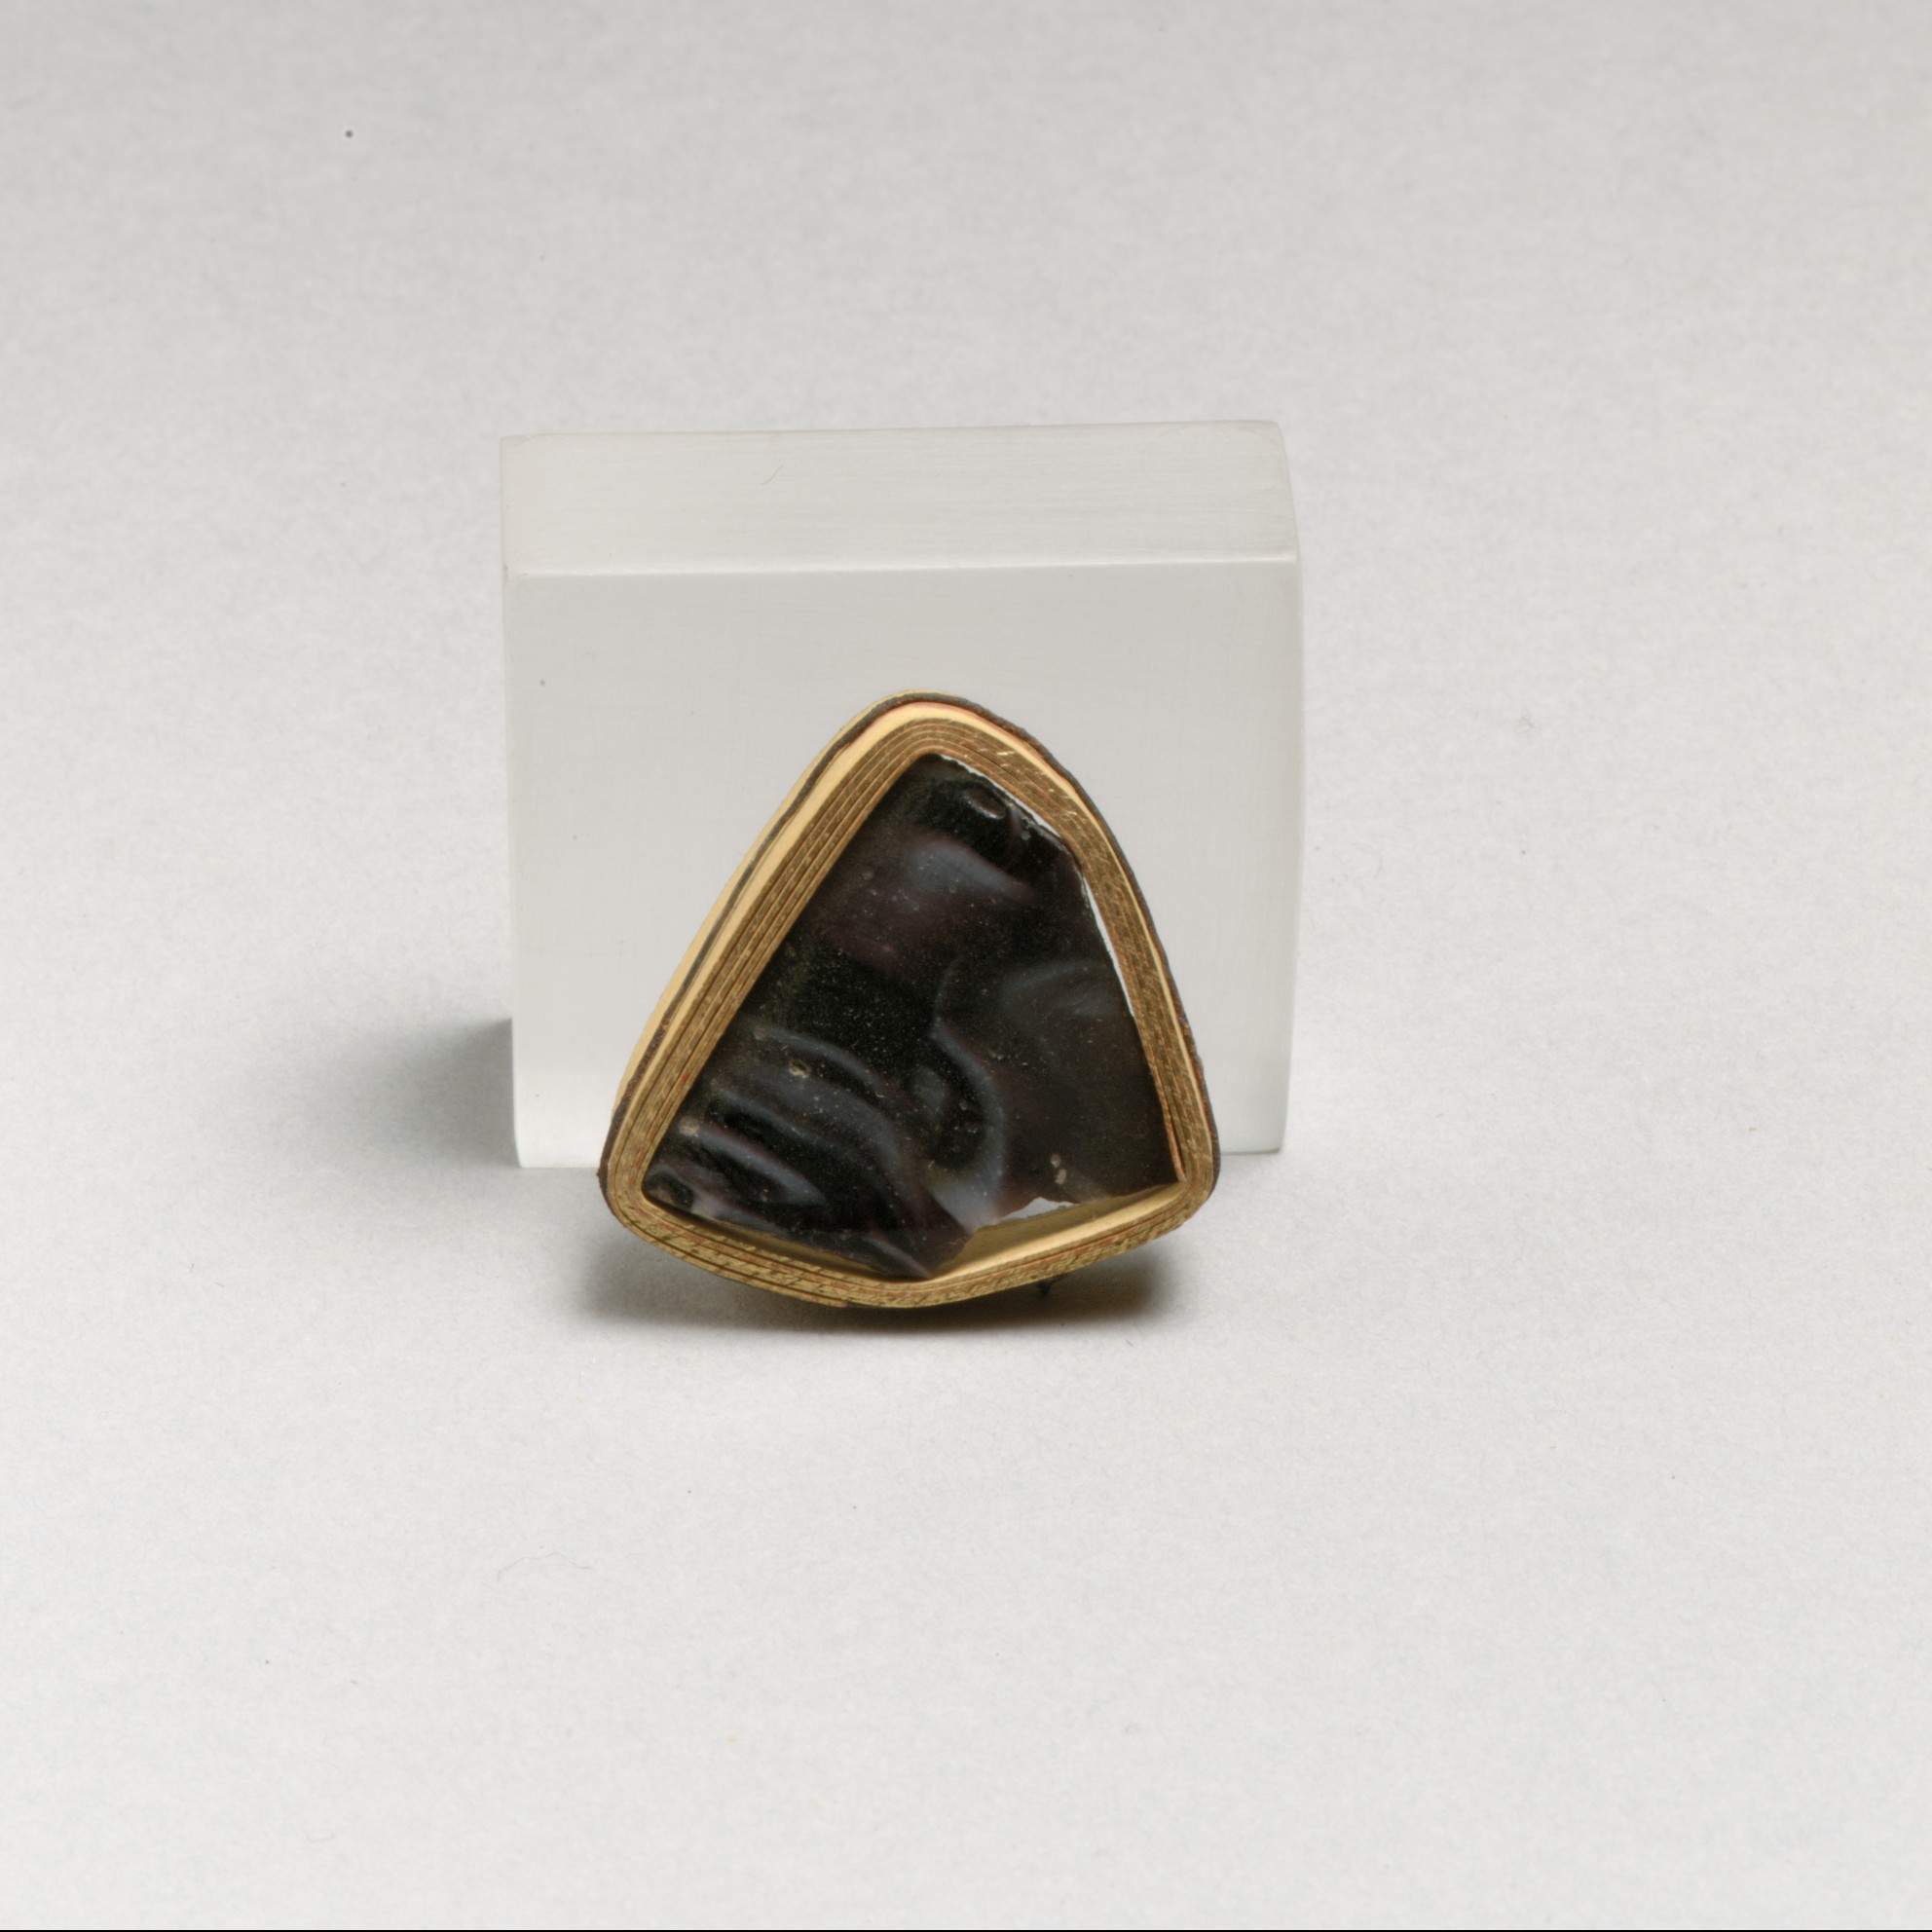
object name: fragment, mosaic bowl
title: Glass mosaic bowl fragment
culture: roman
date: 34 BCE-33 CE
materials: glass